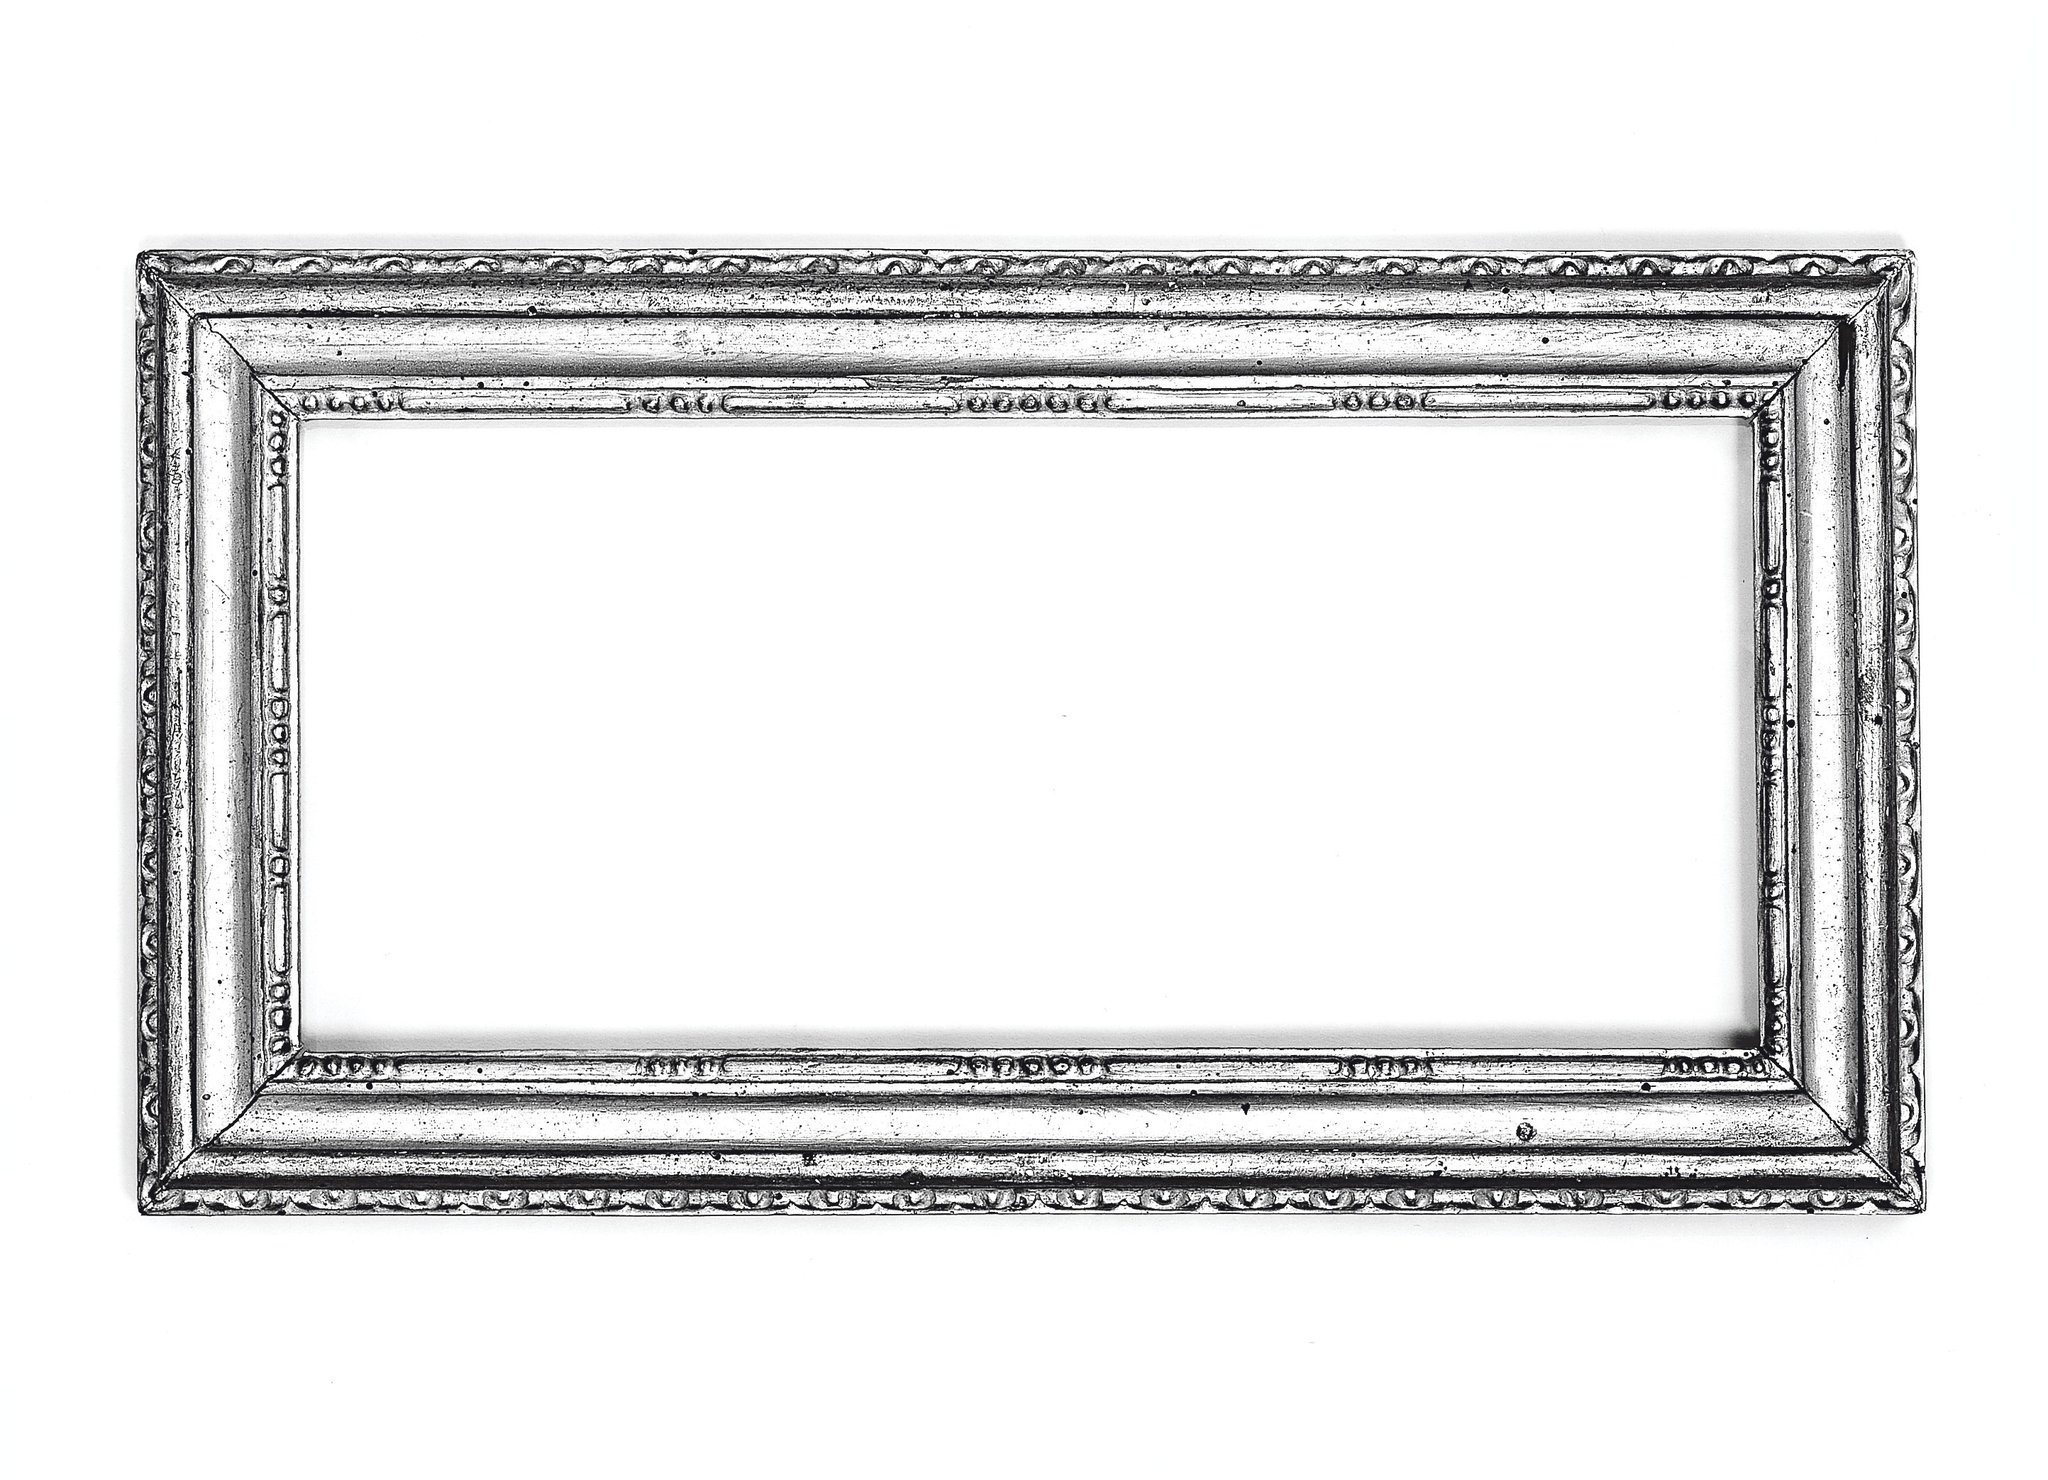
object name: frame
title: Cassetta frame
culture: southern italian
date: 1734-1766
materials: wood